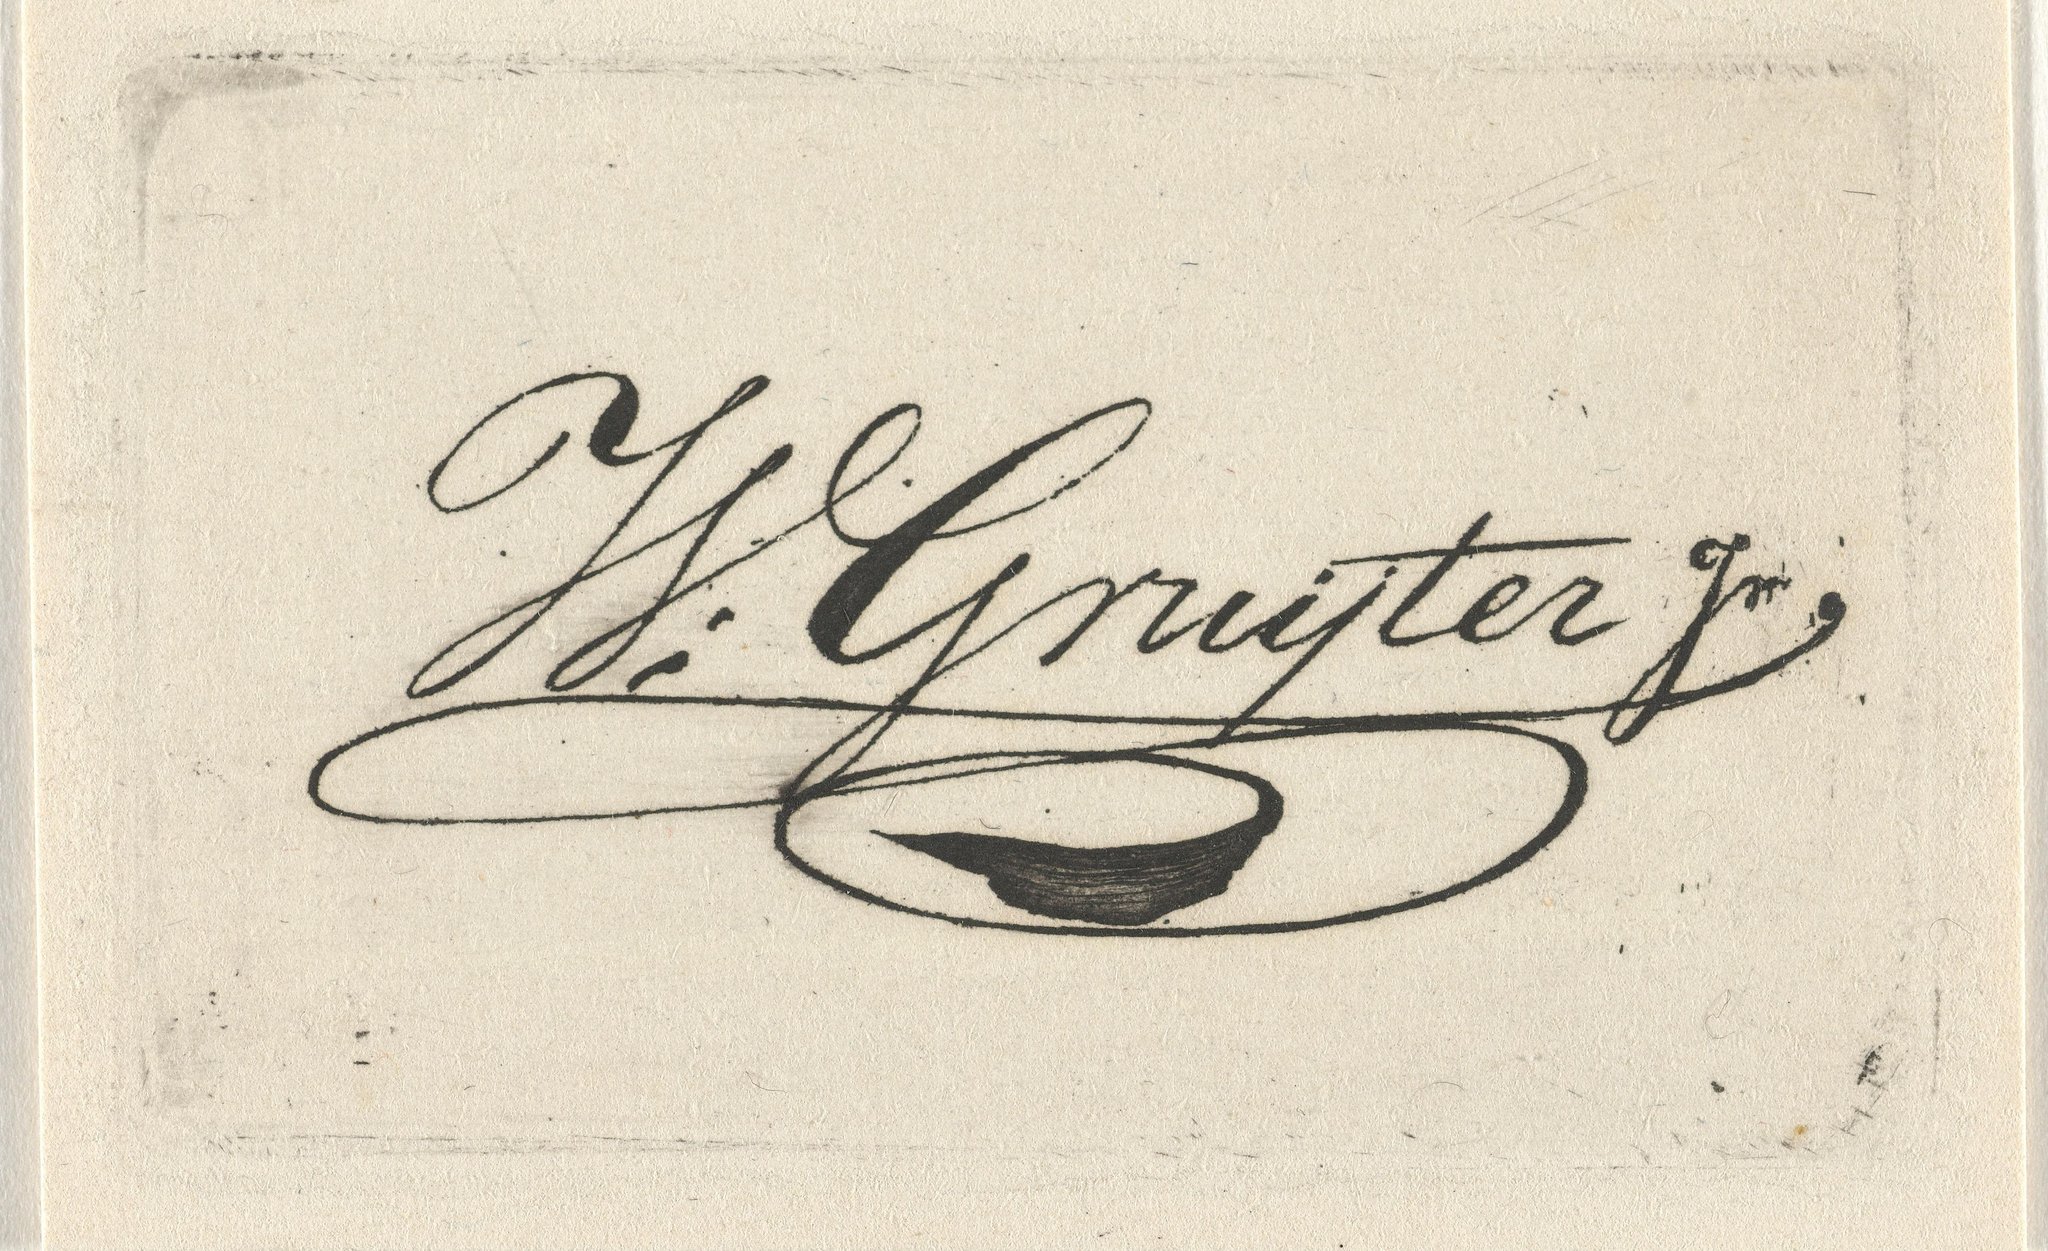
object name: print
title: Signatuur van Willem de Gruyter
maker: willem gruyter jr.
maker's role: draughtsman, print maker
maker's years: 1817-1880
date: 1832-1880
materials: paper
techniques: etching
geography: amsterdam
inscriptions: collector's mark: Lugt 2228